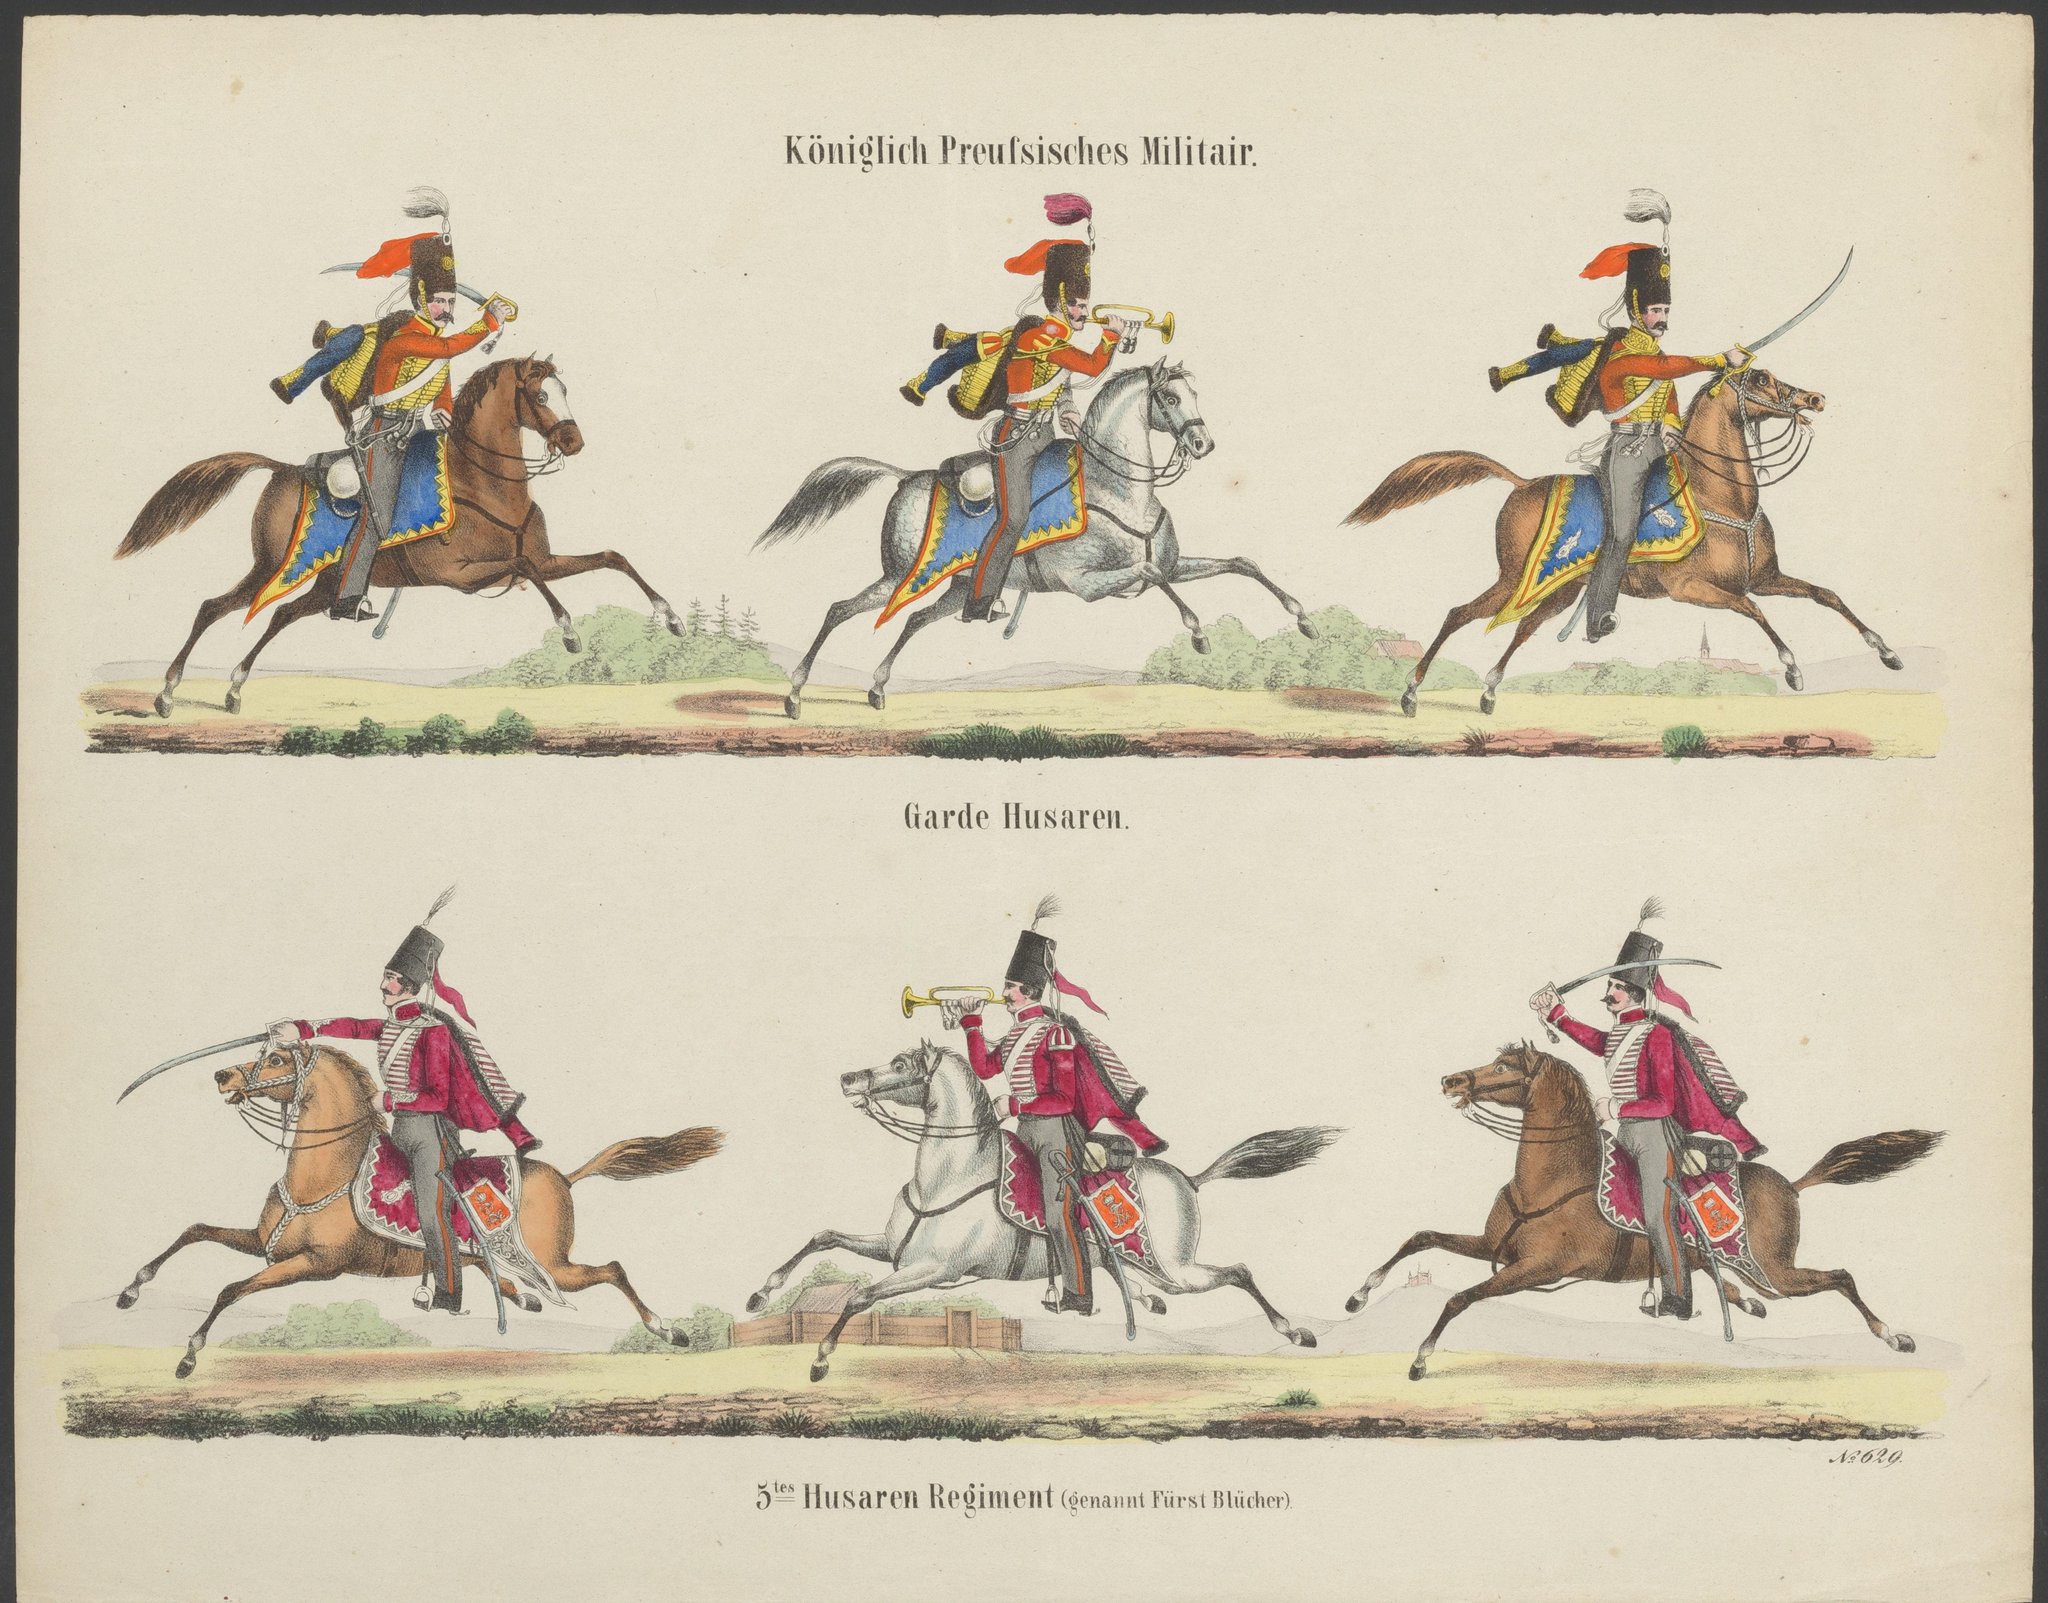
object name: print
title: Koninklijke Pruisische militairen en Huzaren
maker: Anonymous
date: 1800-1899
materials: paper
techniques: hand coloring, lithograph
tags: the company, the unit, the troop ~ military service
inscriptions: collector's mark: Lugt 1641, stamp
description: Twee rijen met op elke rij een voorstelling van een soldaat. Bovenaan drie koninklijke Pruisische soldaten te paard. Onderaan drie soldaten uit het vijfde Huzaren regiment. Rechtsonder genummerd: No. 629. Onderwerpsrubrieken binnen de Atlas Zeden en Gewoonten: Zeden en Gewoonten in Engeren Zin, Des menschen beging, midden en einde, Kinderleven – Kinderspel en Kinderprenten.